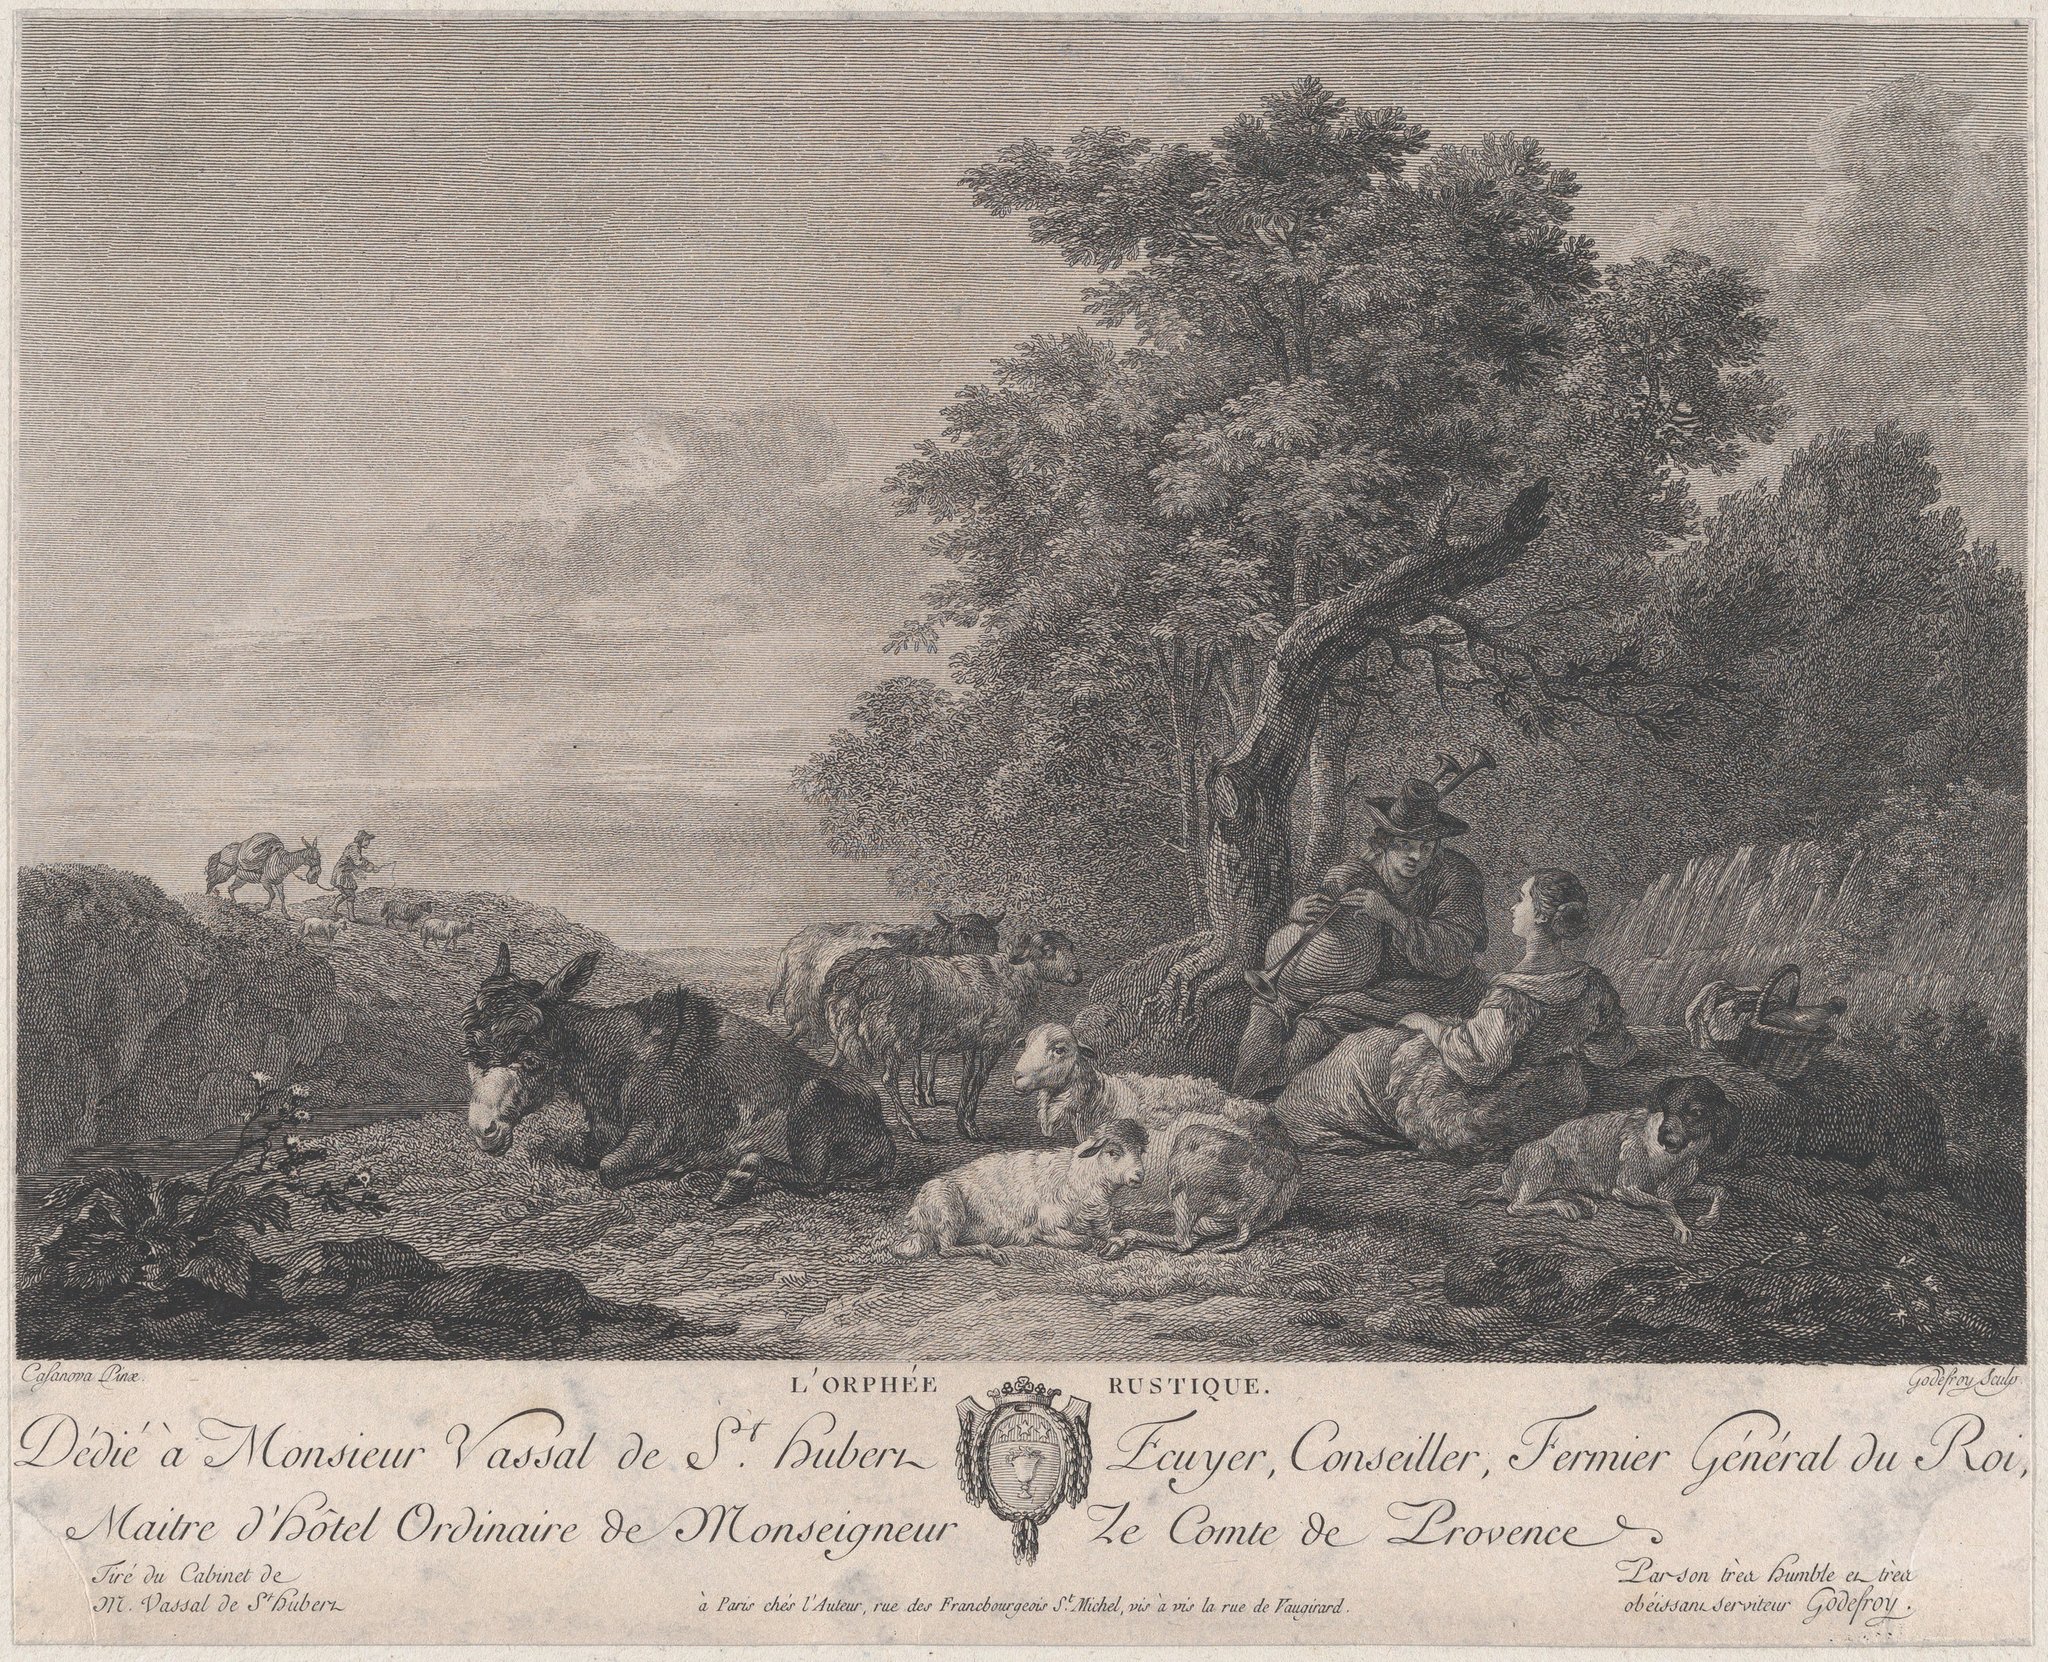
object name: print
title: The Rustic Orpheus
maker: françois godefroy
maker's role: artist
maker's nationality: french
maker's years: 1743-1819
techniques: etching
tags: women,orpheus,dogs,donkeys,sheep